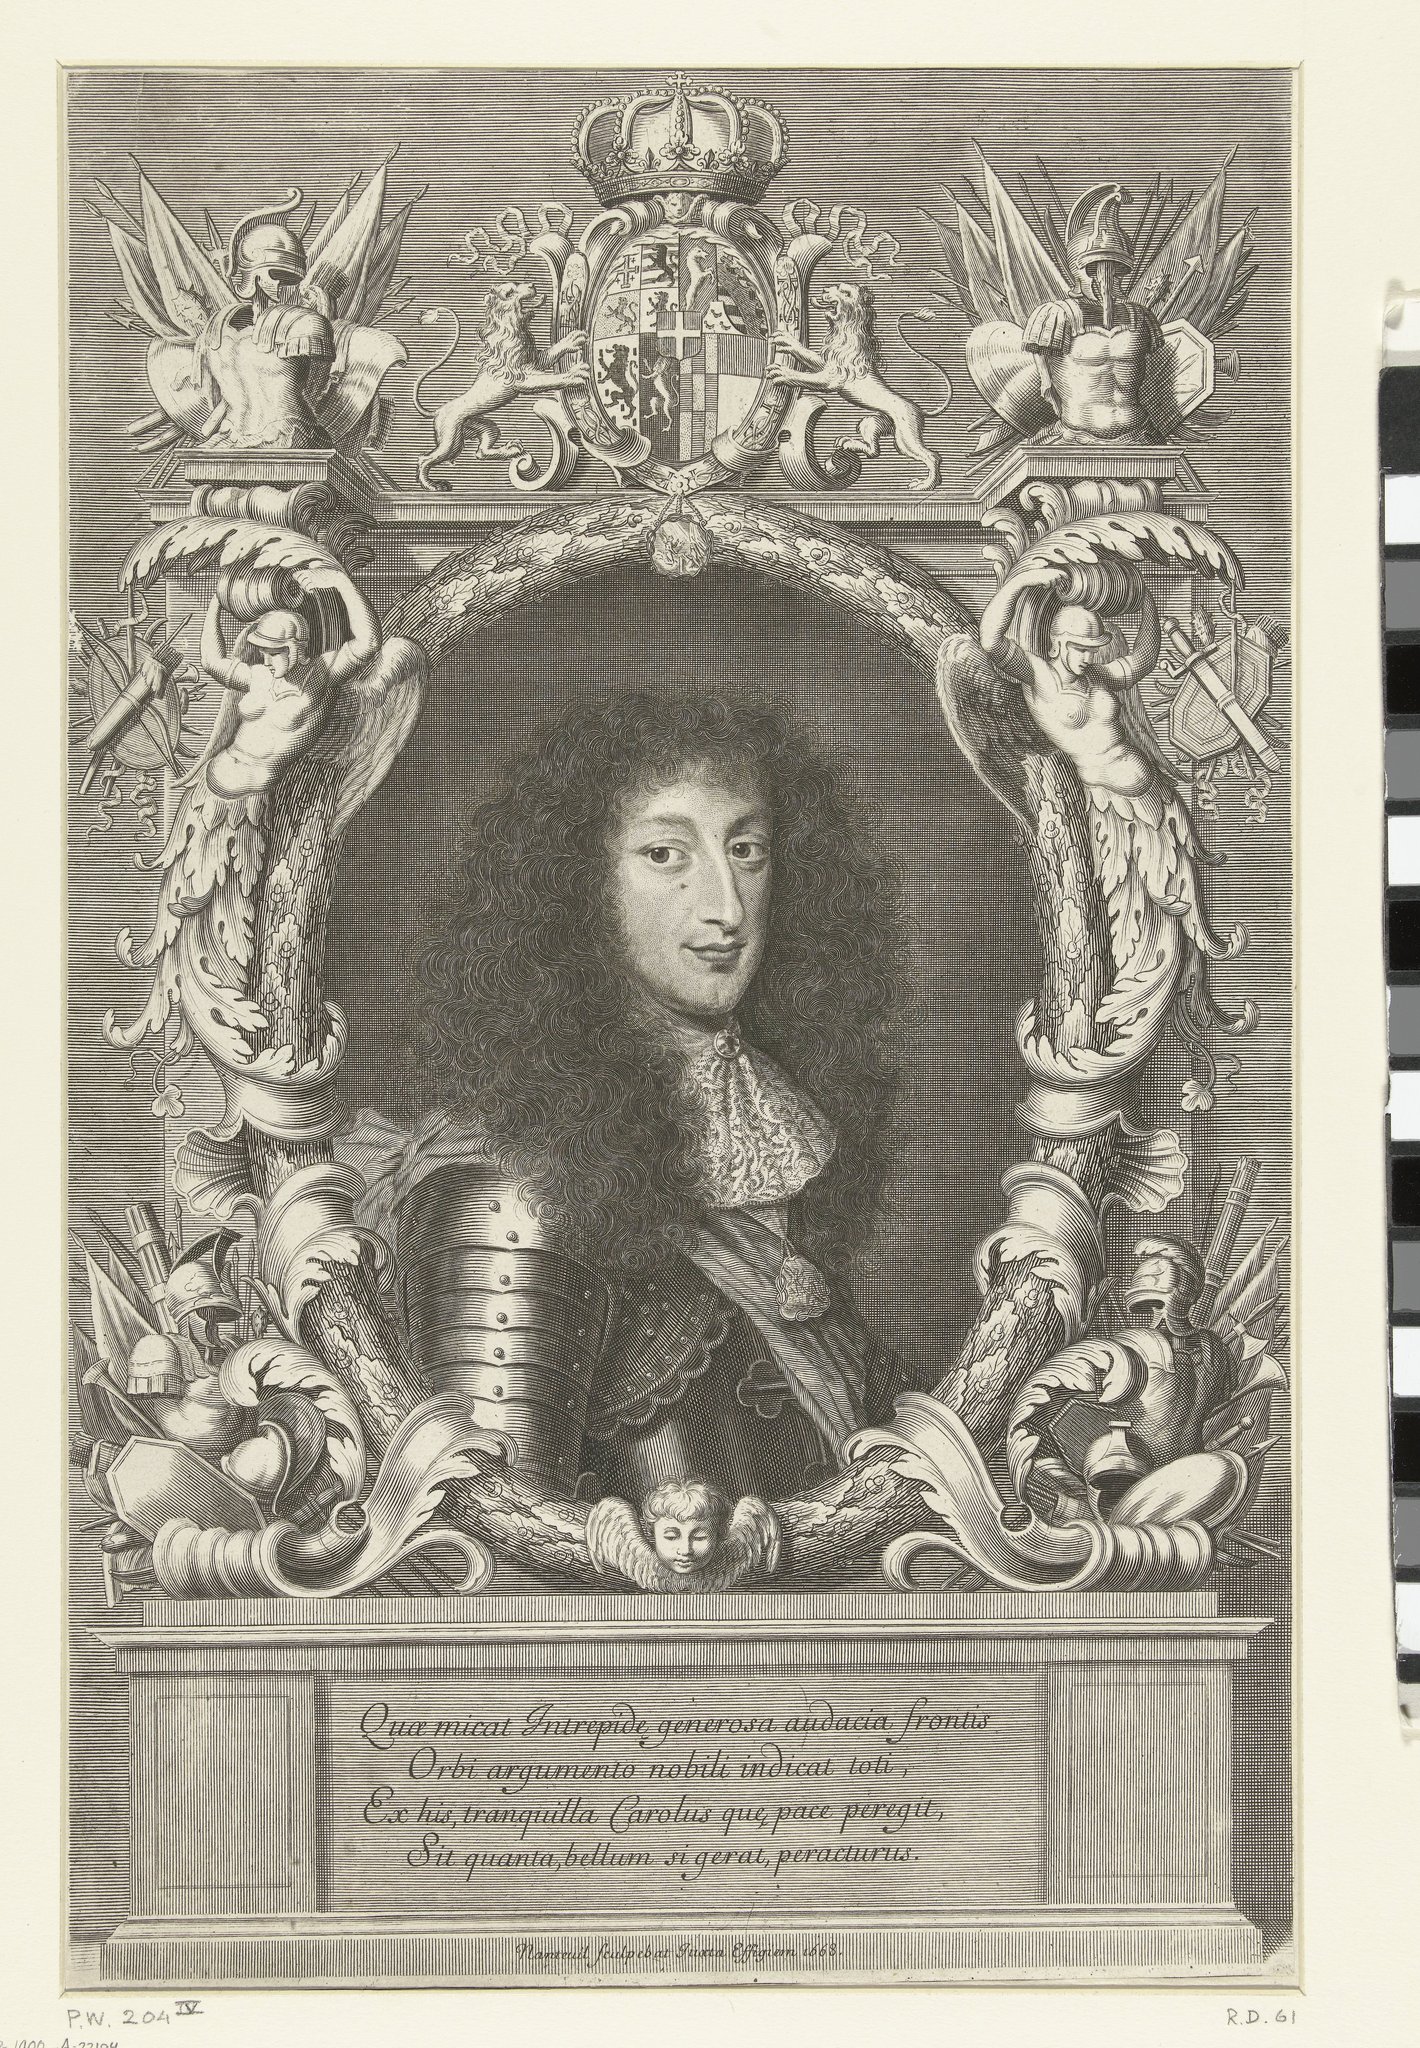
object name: print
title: Portret van Karel Emanuel II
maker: robert nanteuil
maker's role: print maker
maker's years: 1623-1678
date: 1668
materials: paper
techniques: engraving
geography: france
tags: turijn, karel emanuel ii (hertog van savoye)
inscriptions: collector's mark: Lugt 2228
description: Portret van Karel Emanuel II, hertog van Savoye, in een ovale omlijsting van eikenbladeren, omgeven door wapentuig en twee gevleugelde figuren met een onderlichaam van acanthusbladeren. Bovenaan een wapenschild met kroon, geflankeerd door leeuwen. Op de sokkel een vierregelige tekst in het Latijn.